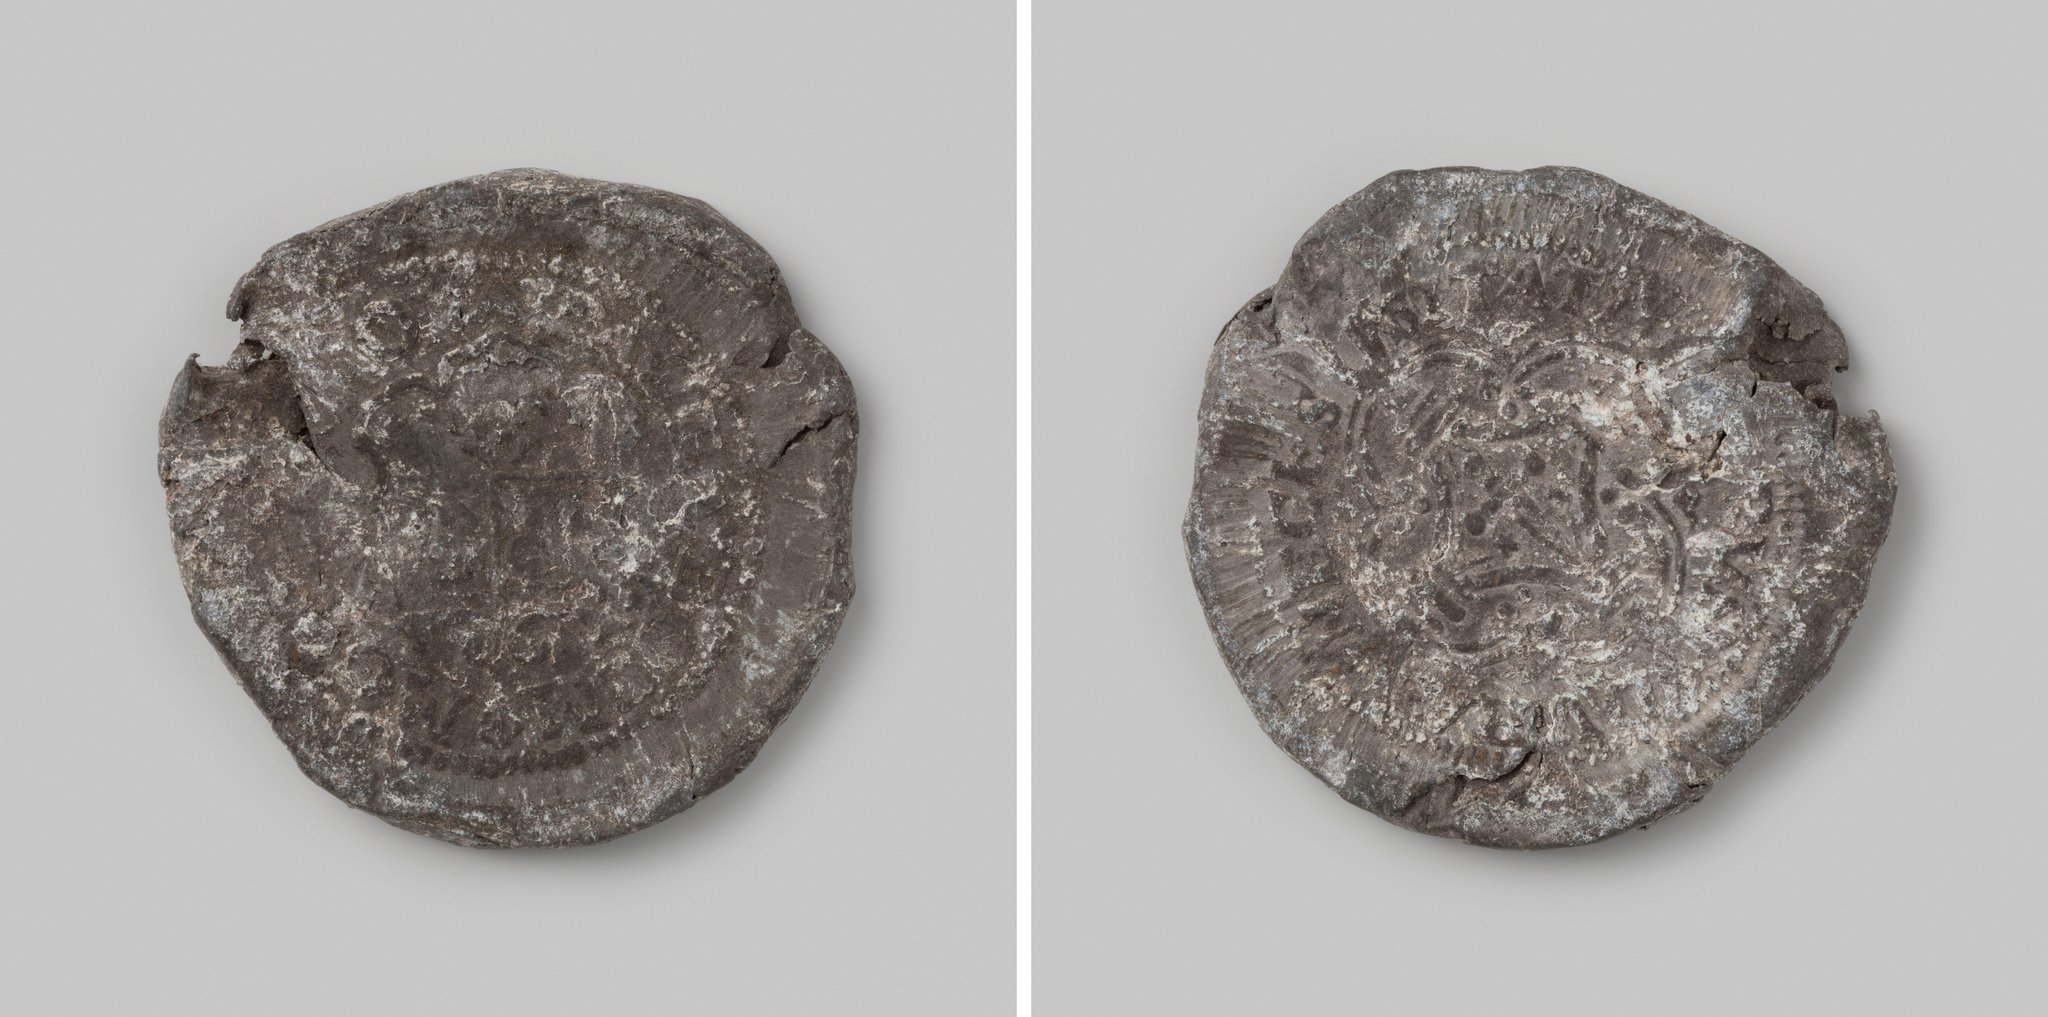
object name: coin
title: Stad Zaltbommel, stuiver. Afslag in lood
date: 1579-1582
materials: lead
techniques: striking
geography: zaltbommel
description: Loden afslag van een zilveren munt. Voorzijde: wapenschild van de stad. Omschrift: MONETA NOVA FACTA BOEM. Keerzijde: vierpas, waarop lang gelelied kruis met in het midden een omhoog stekend zwaard met aan weerzijden daarvan een rozet. Omschrift: [ondetermineerbaar muntteken] DVRAE (A en E verbonden)-NECES-SITATI-S OPVS. Afslag in lood, vervaardigd met in Zaltbommel nog aanwezige stempels.